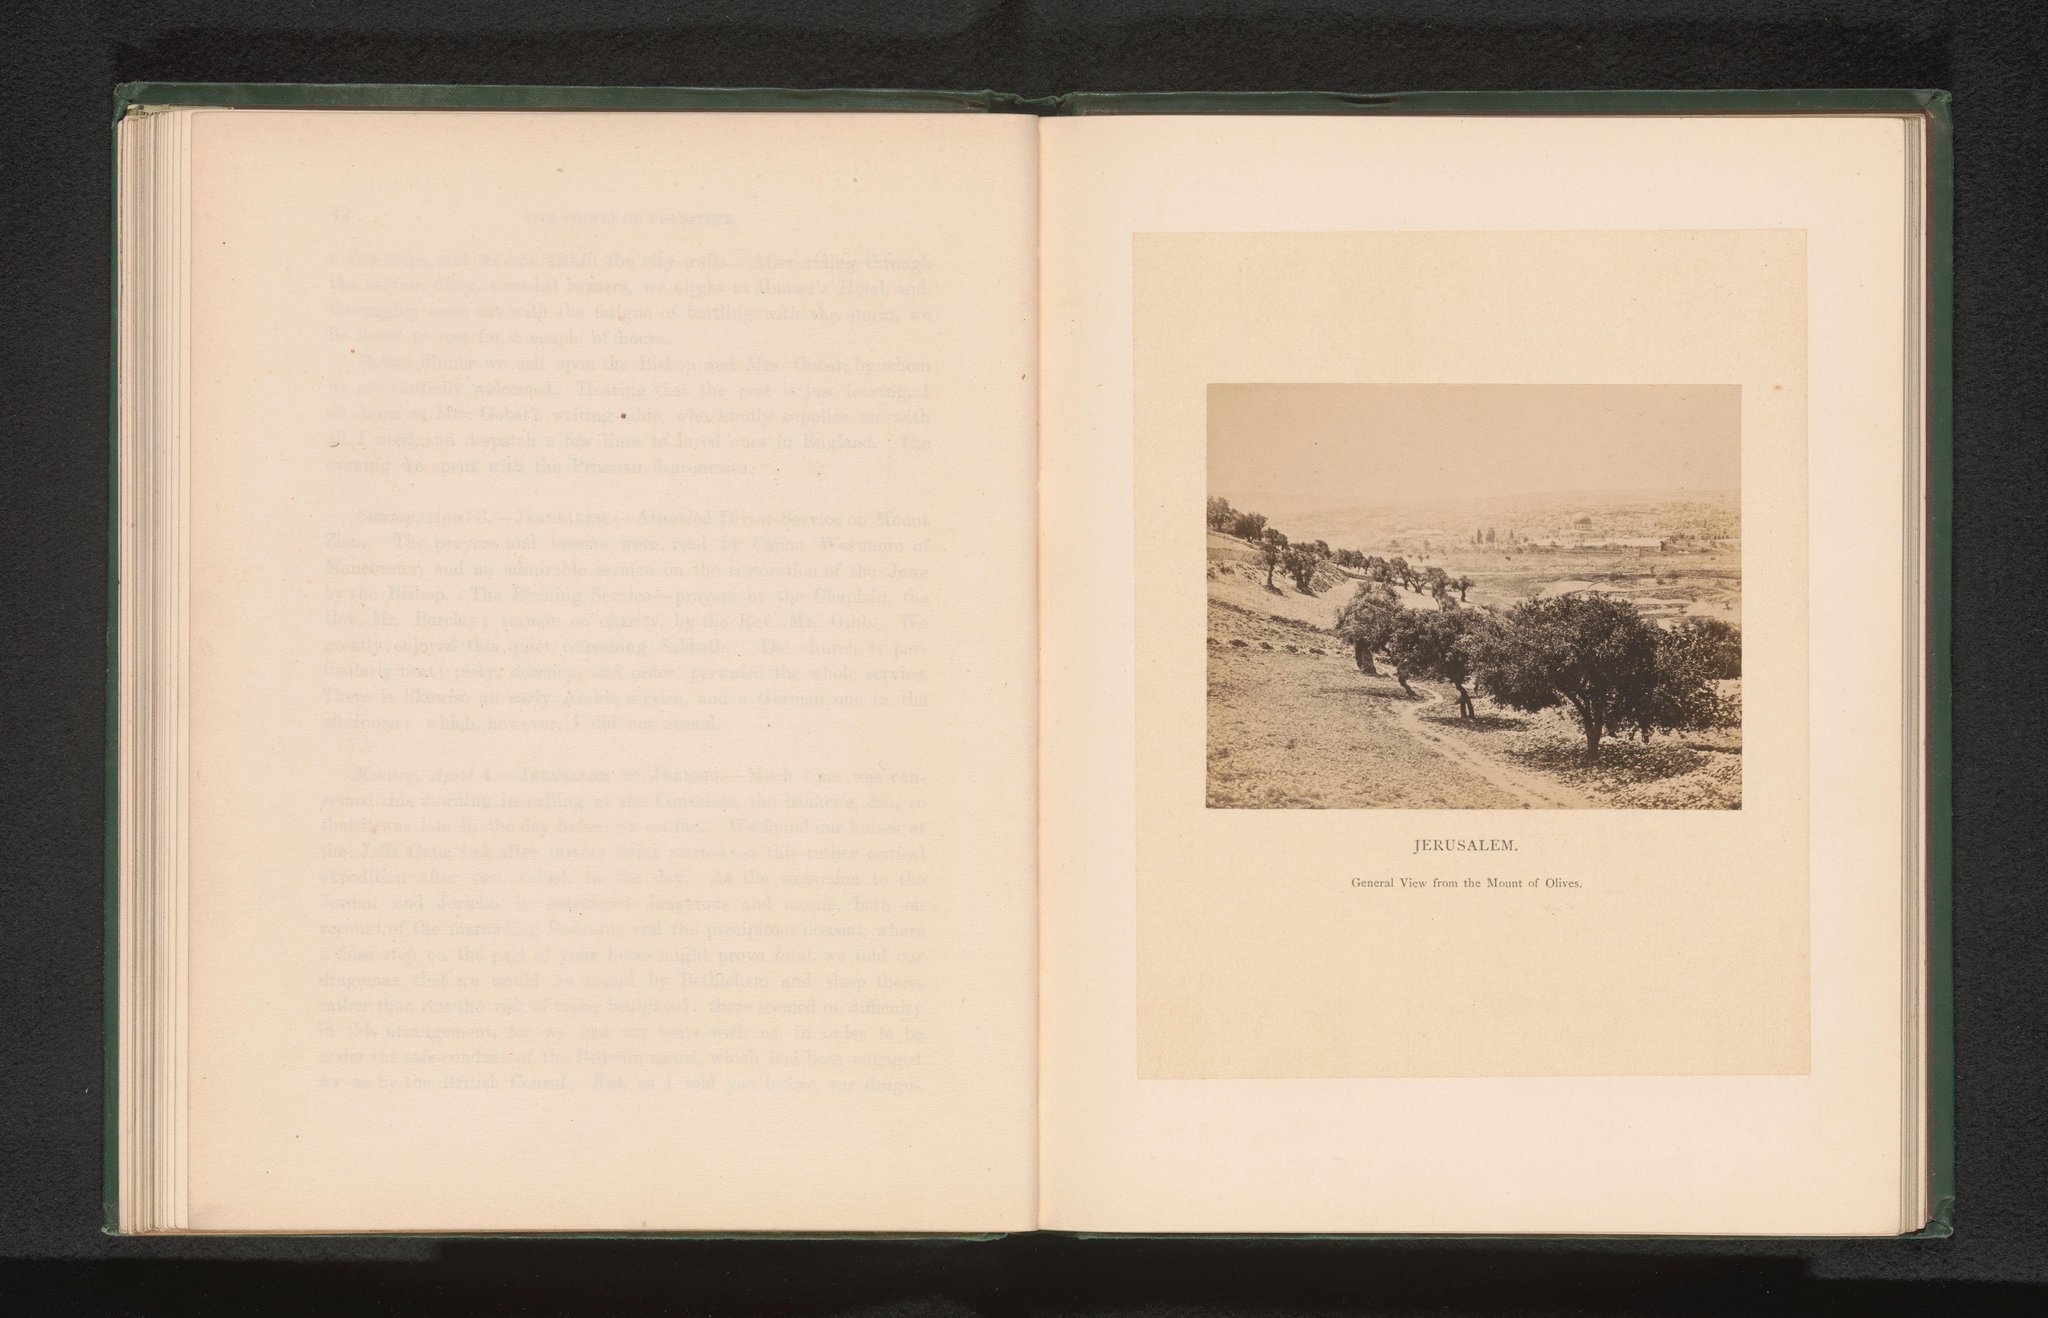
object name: page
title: Jerusalem. General view from the Mount of Olives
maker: francis bedford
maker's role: print maker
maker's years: 1815-1894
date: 1860-1865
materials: photographic support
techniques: albumen print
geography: olijfberg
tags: city-view in general; 'veduta'